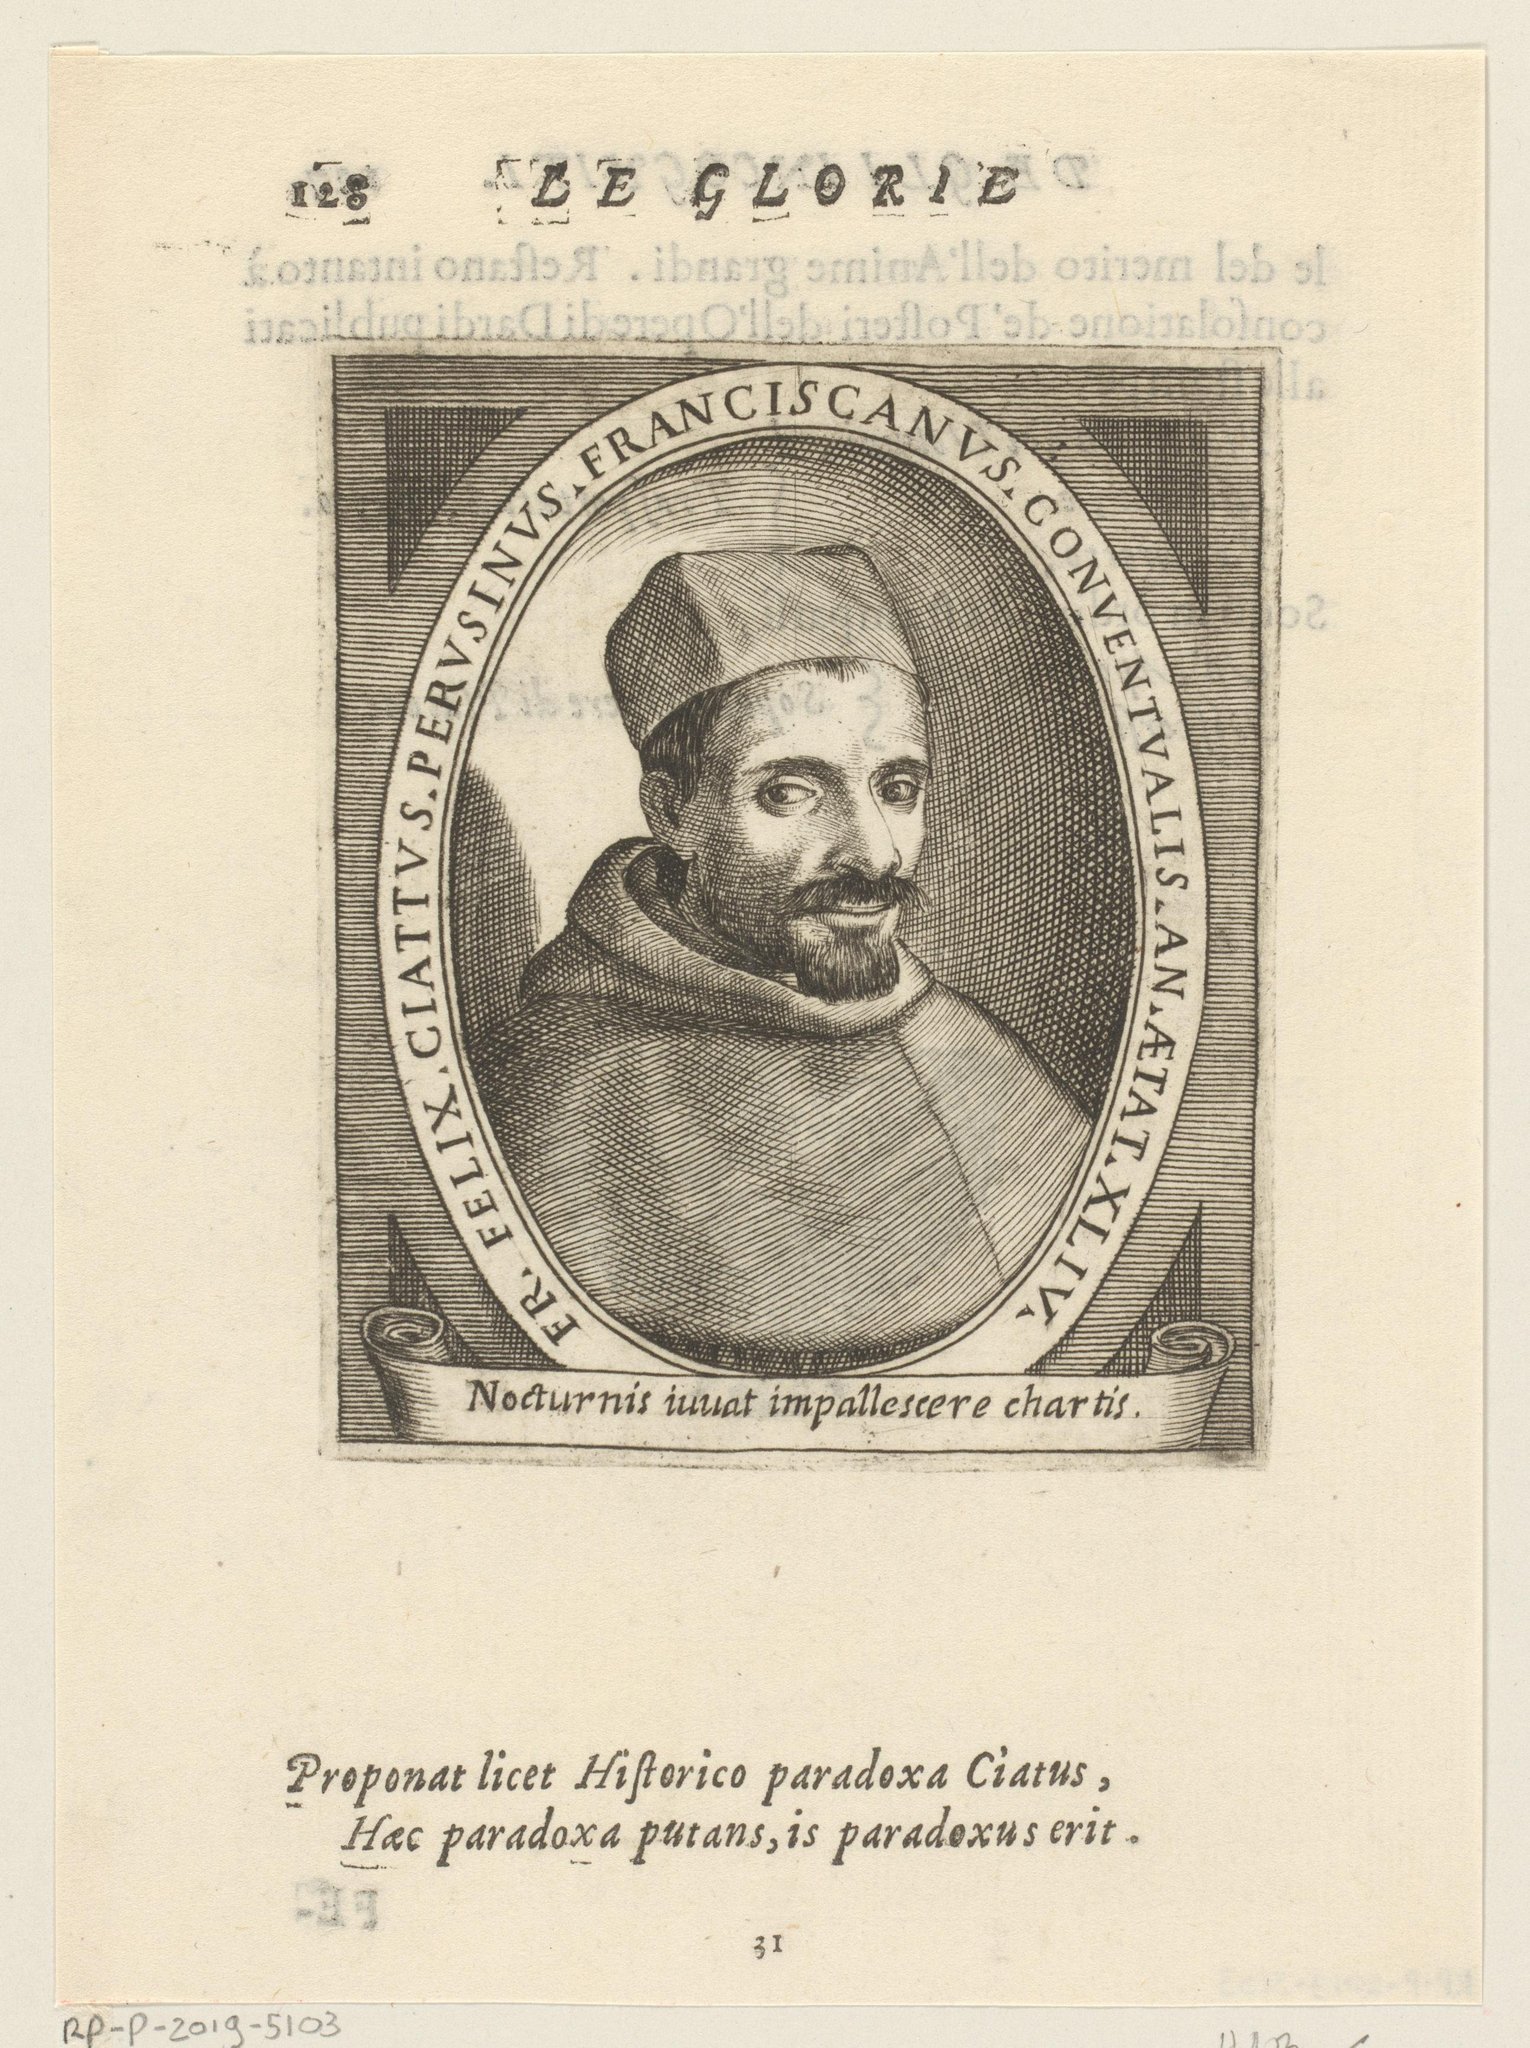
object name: print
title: Portret van Felice Ciatti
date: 1647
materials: paper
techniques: engraving, letterpress printing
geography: venice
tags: historical persons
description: Prent uit: Le glorie degli Incogniti o vero gli huomini illustri dell'accademia de signori Incogniti di Venetia. Venetië: Francesco Valvasense, 1647, p. 128.